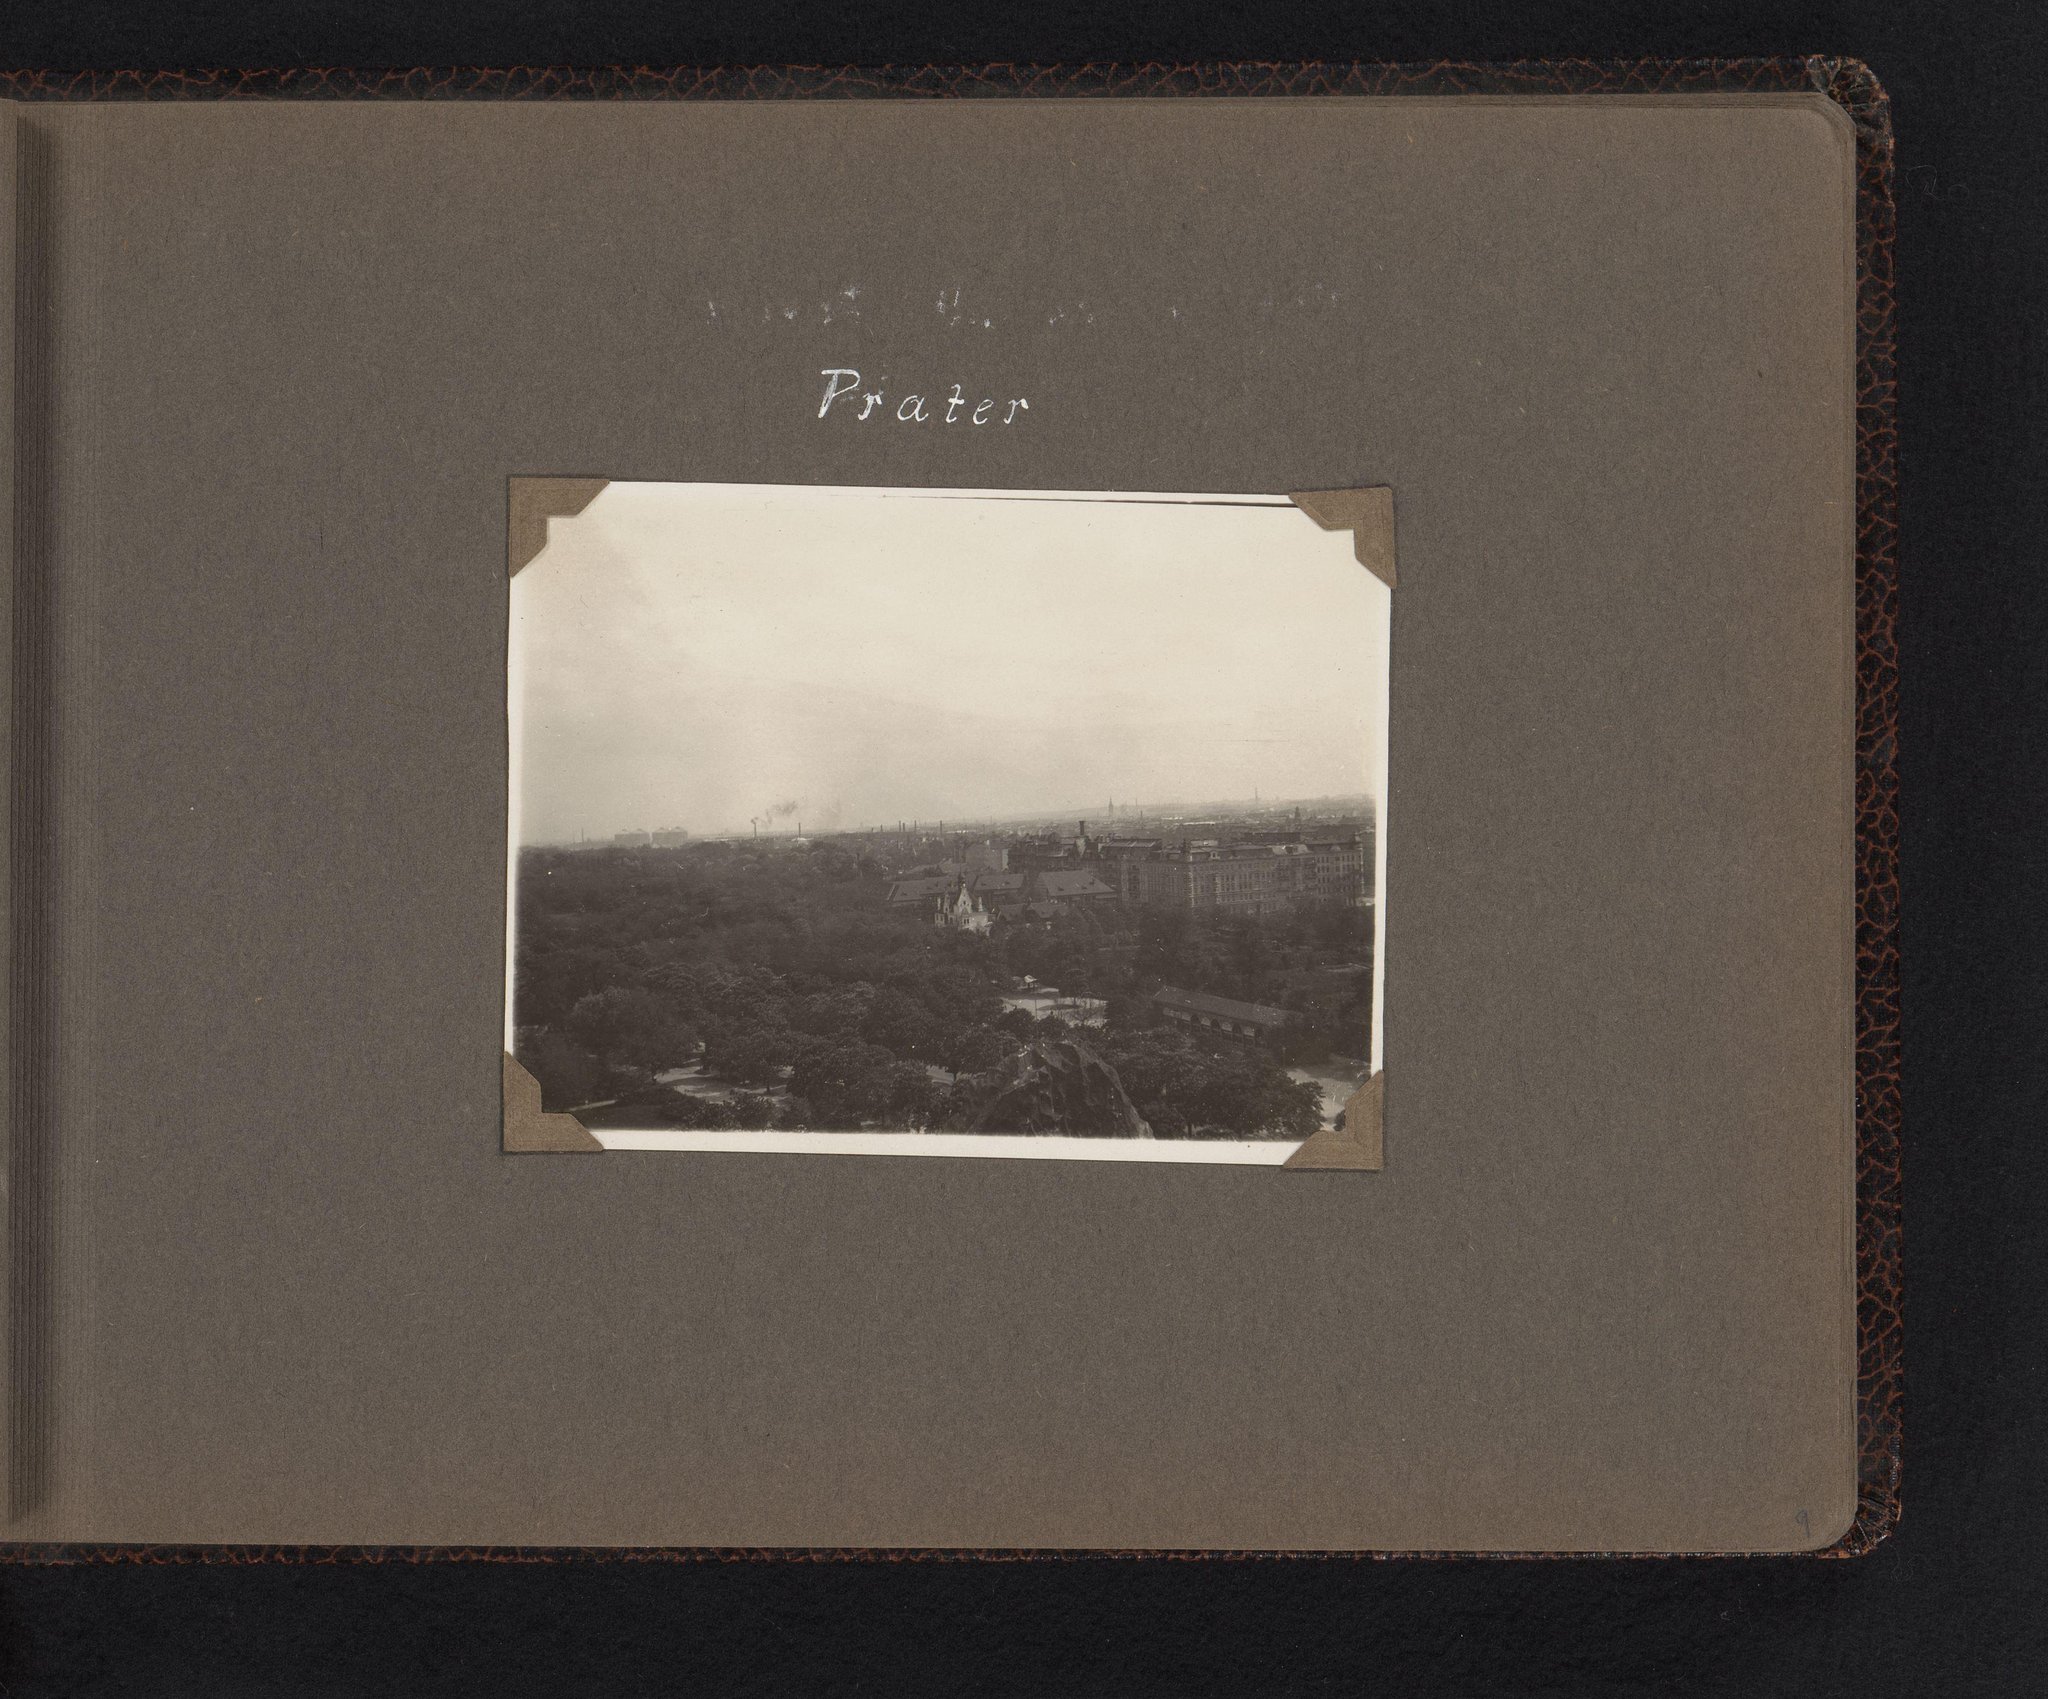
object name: photograph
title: Gezicht op het Prater te Wenen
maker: berti hoppe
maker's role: fotograaf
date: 1930-1931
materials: cardboard, paper, photographic support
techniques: gelatin silver print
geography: vienna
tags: city-view in general; 'veduta', public gardens, park, vienna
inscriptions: annotation: ‘[...] Prater’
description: Deze pagina maakt deel uit van een album.